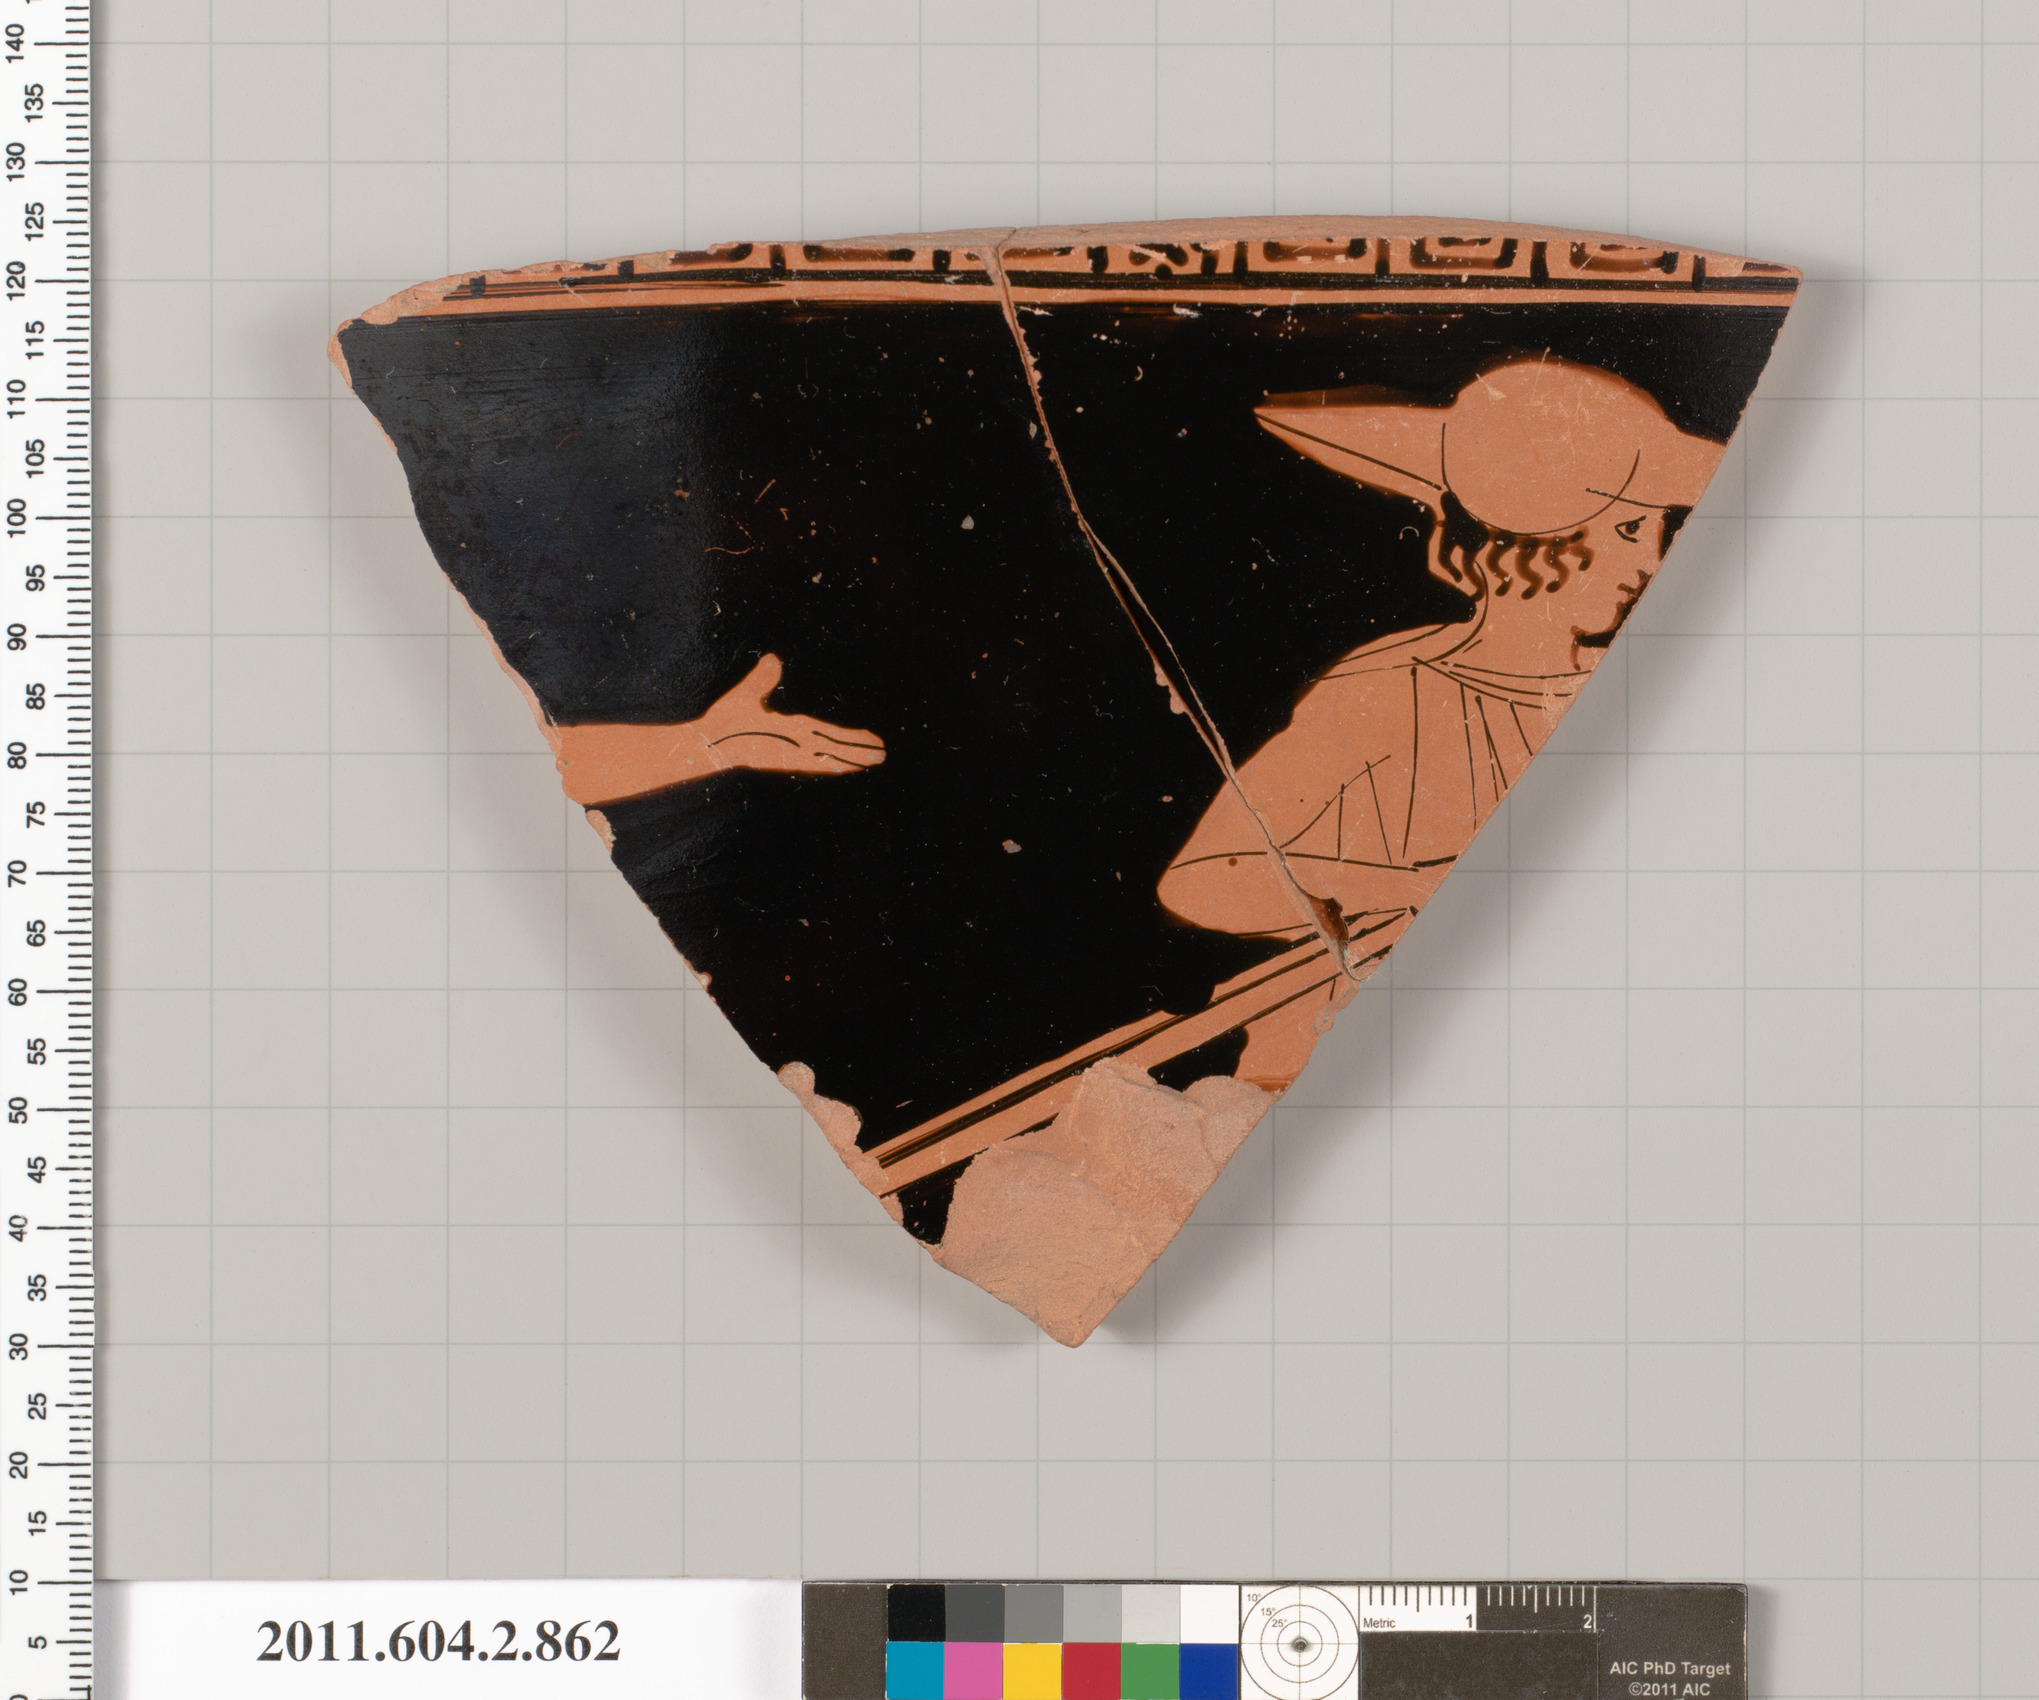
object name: bell krater fragment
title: Terracotta fragment of a bell-krater (bowl for mixing wine and water)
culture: greek, attic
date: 460-450 BCE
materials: terracotta